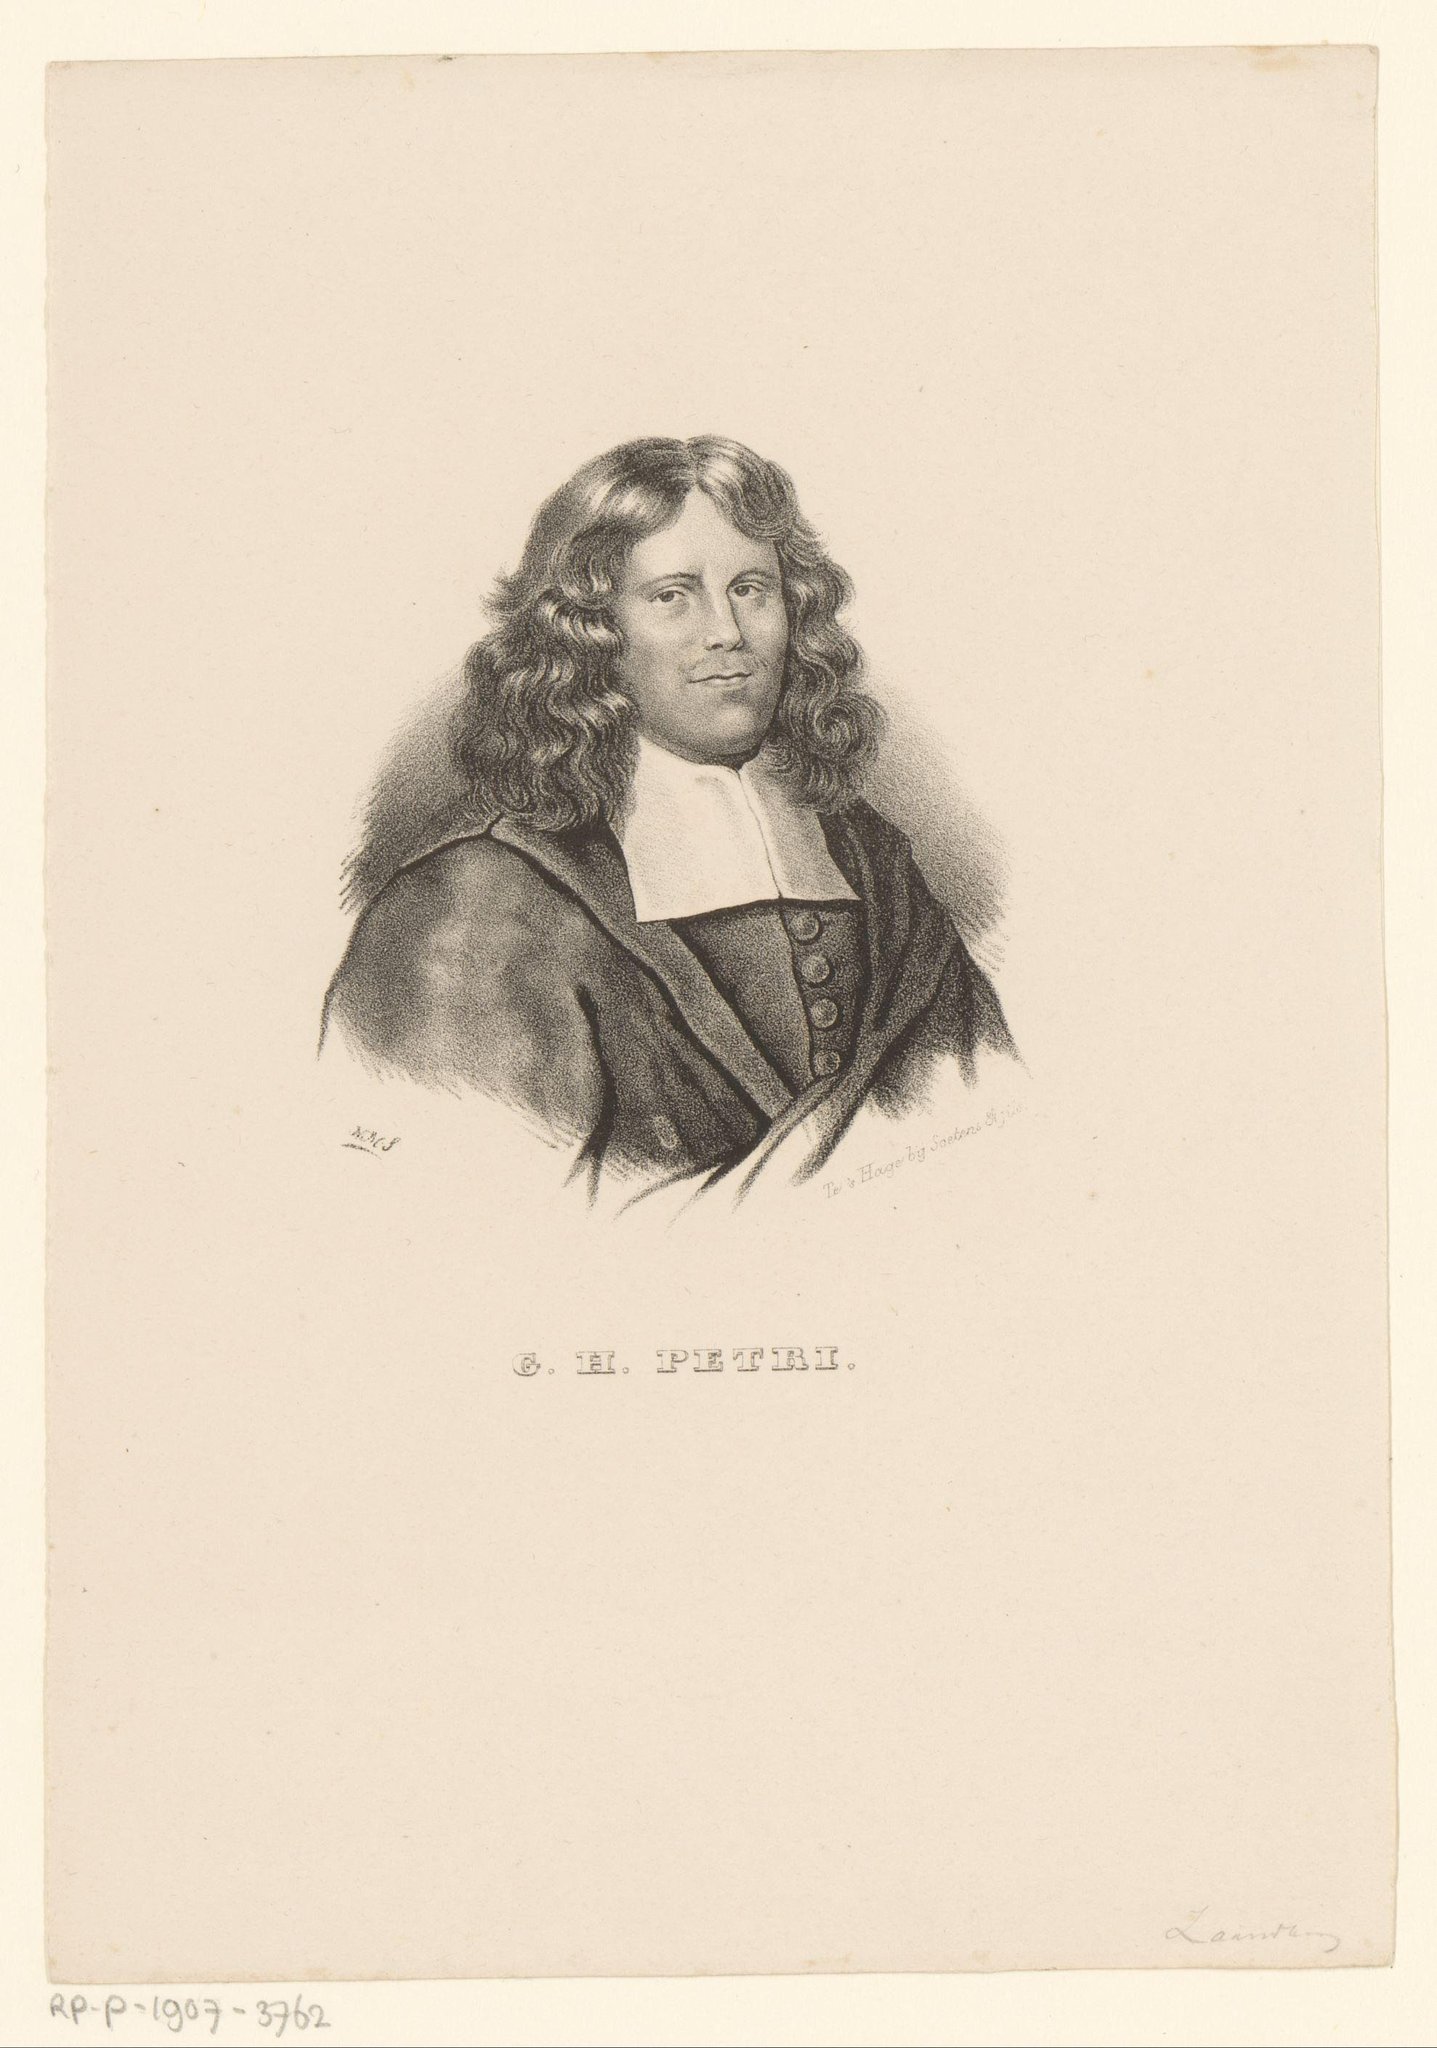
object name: print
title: Portret van Georg Henrik Petri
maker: nicolaas martinus schild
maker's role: draughtsman, print maker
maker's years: 1822-1840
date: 1837-1840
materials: paper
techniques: lithograph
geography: the hague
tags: amsterdam, historical persons (+ (full) bust portrait)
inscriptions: collector's mark: Lugt 2228